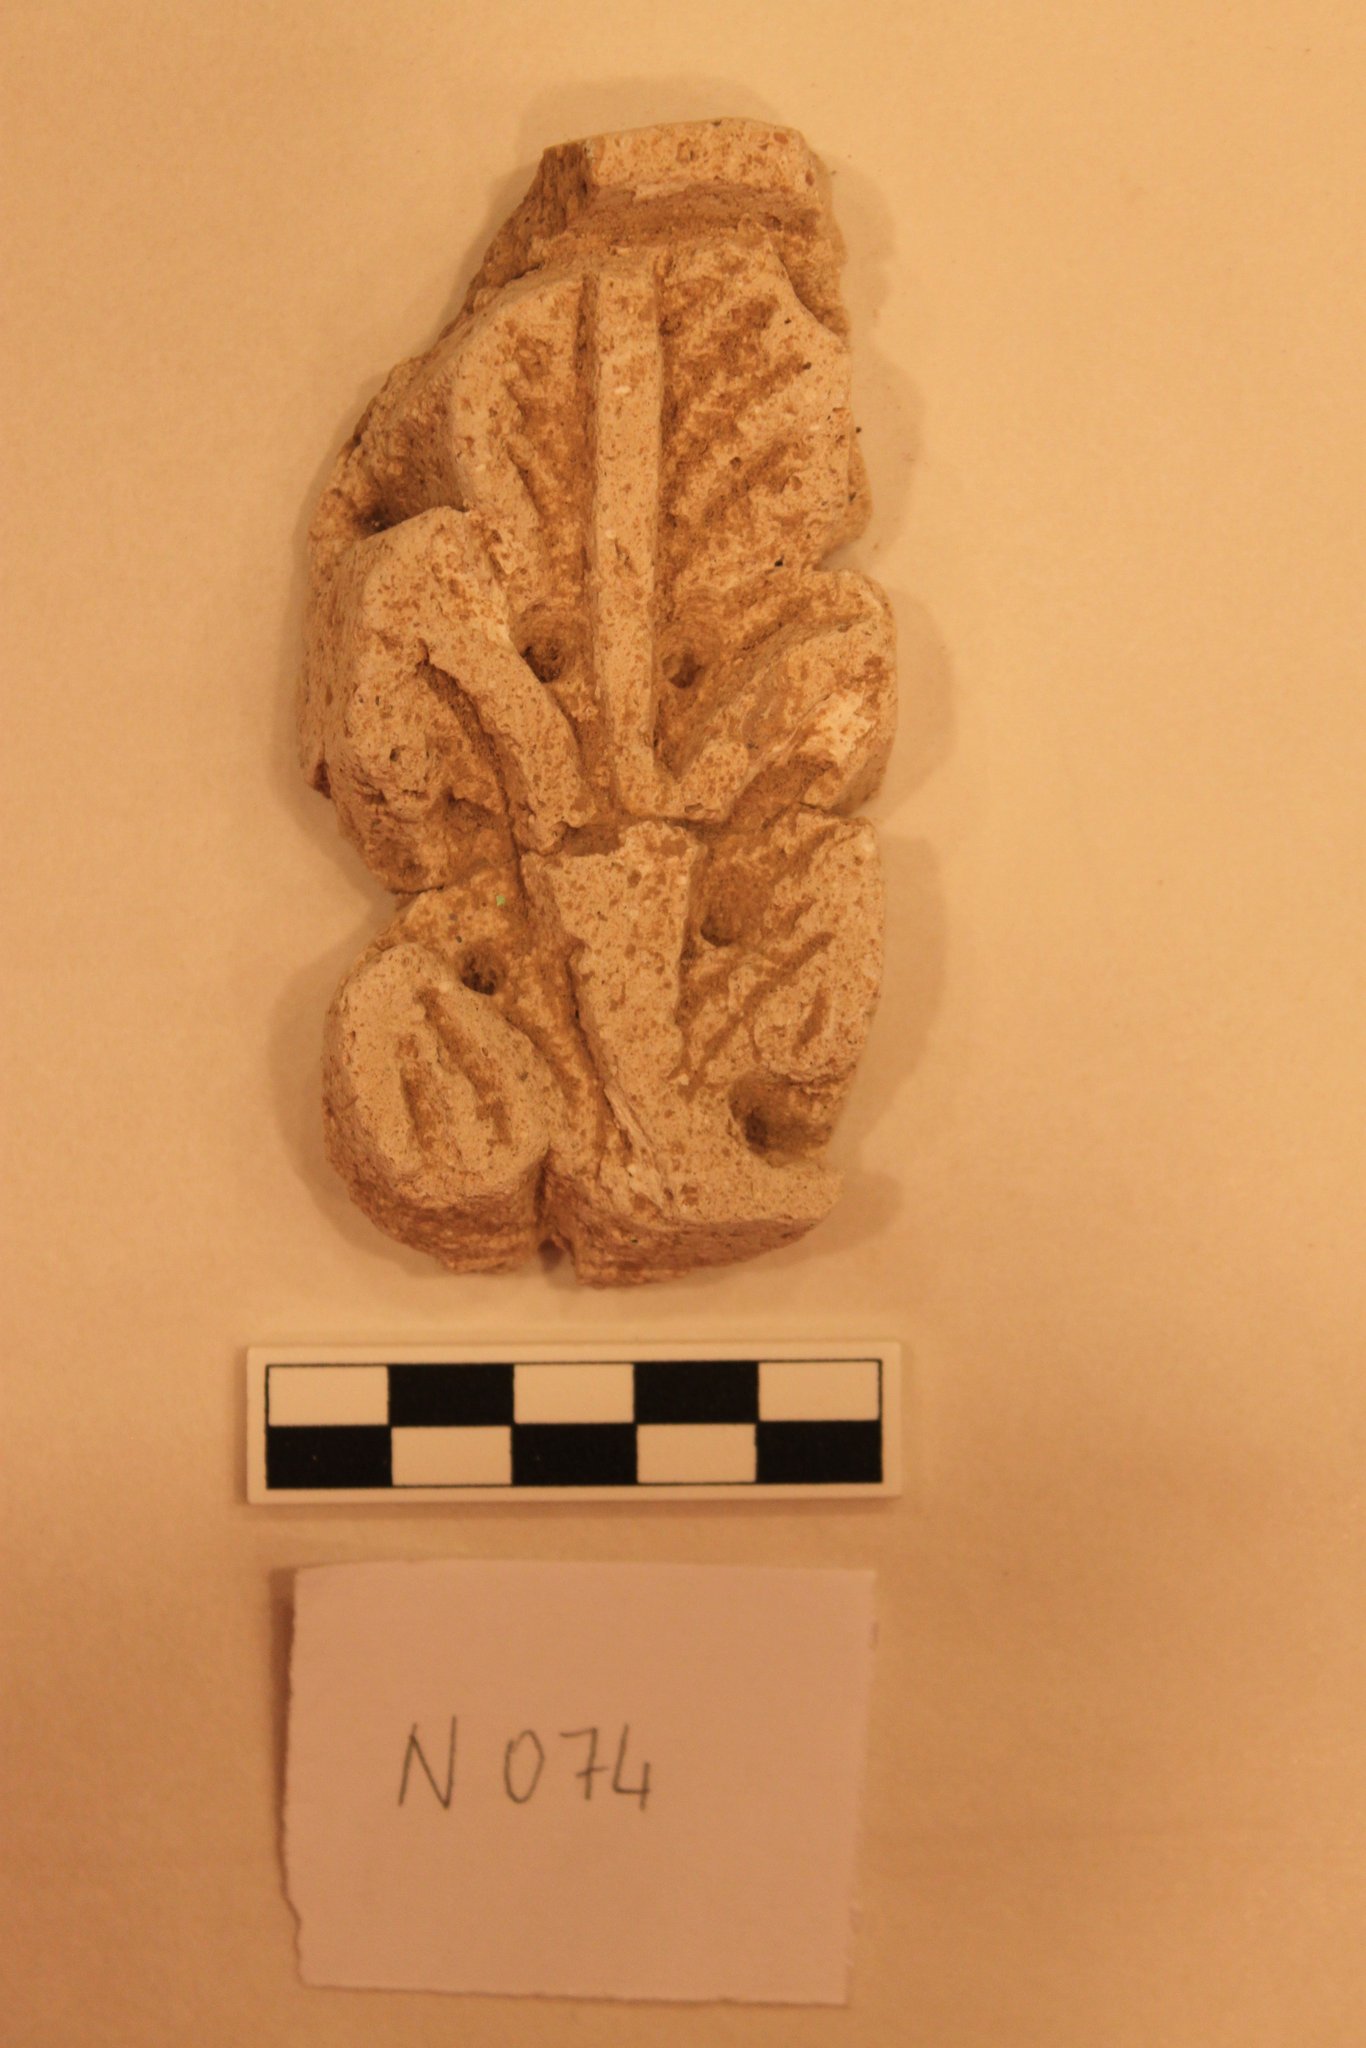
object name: fragment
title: Stucco Fragment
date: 701-1200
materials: plaster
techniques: carving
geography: iran